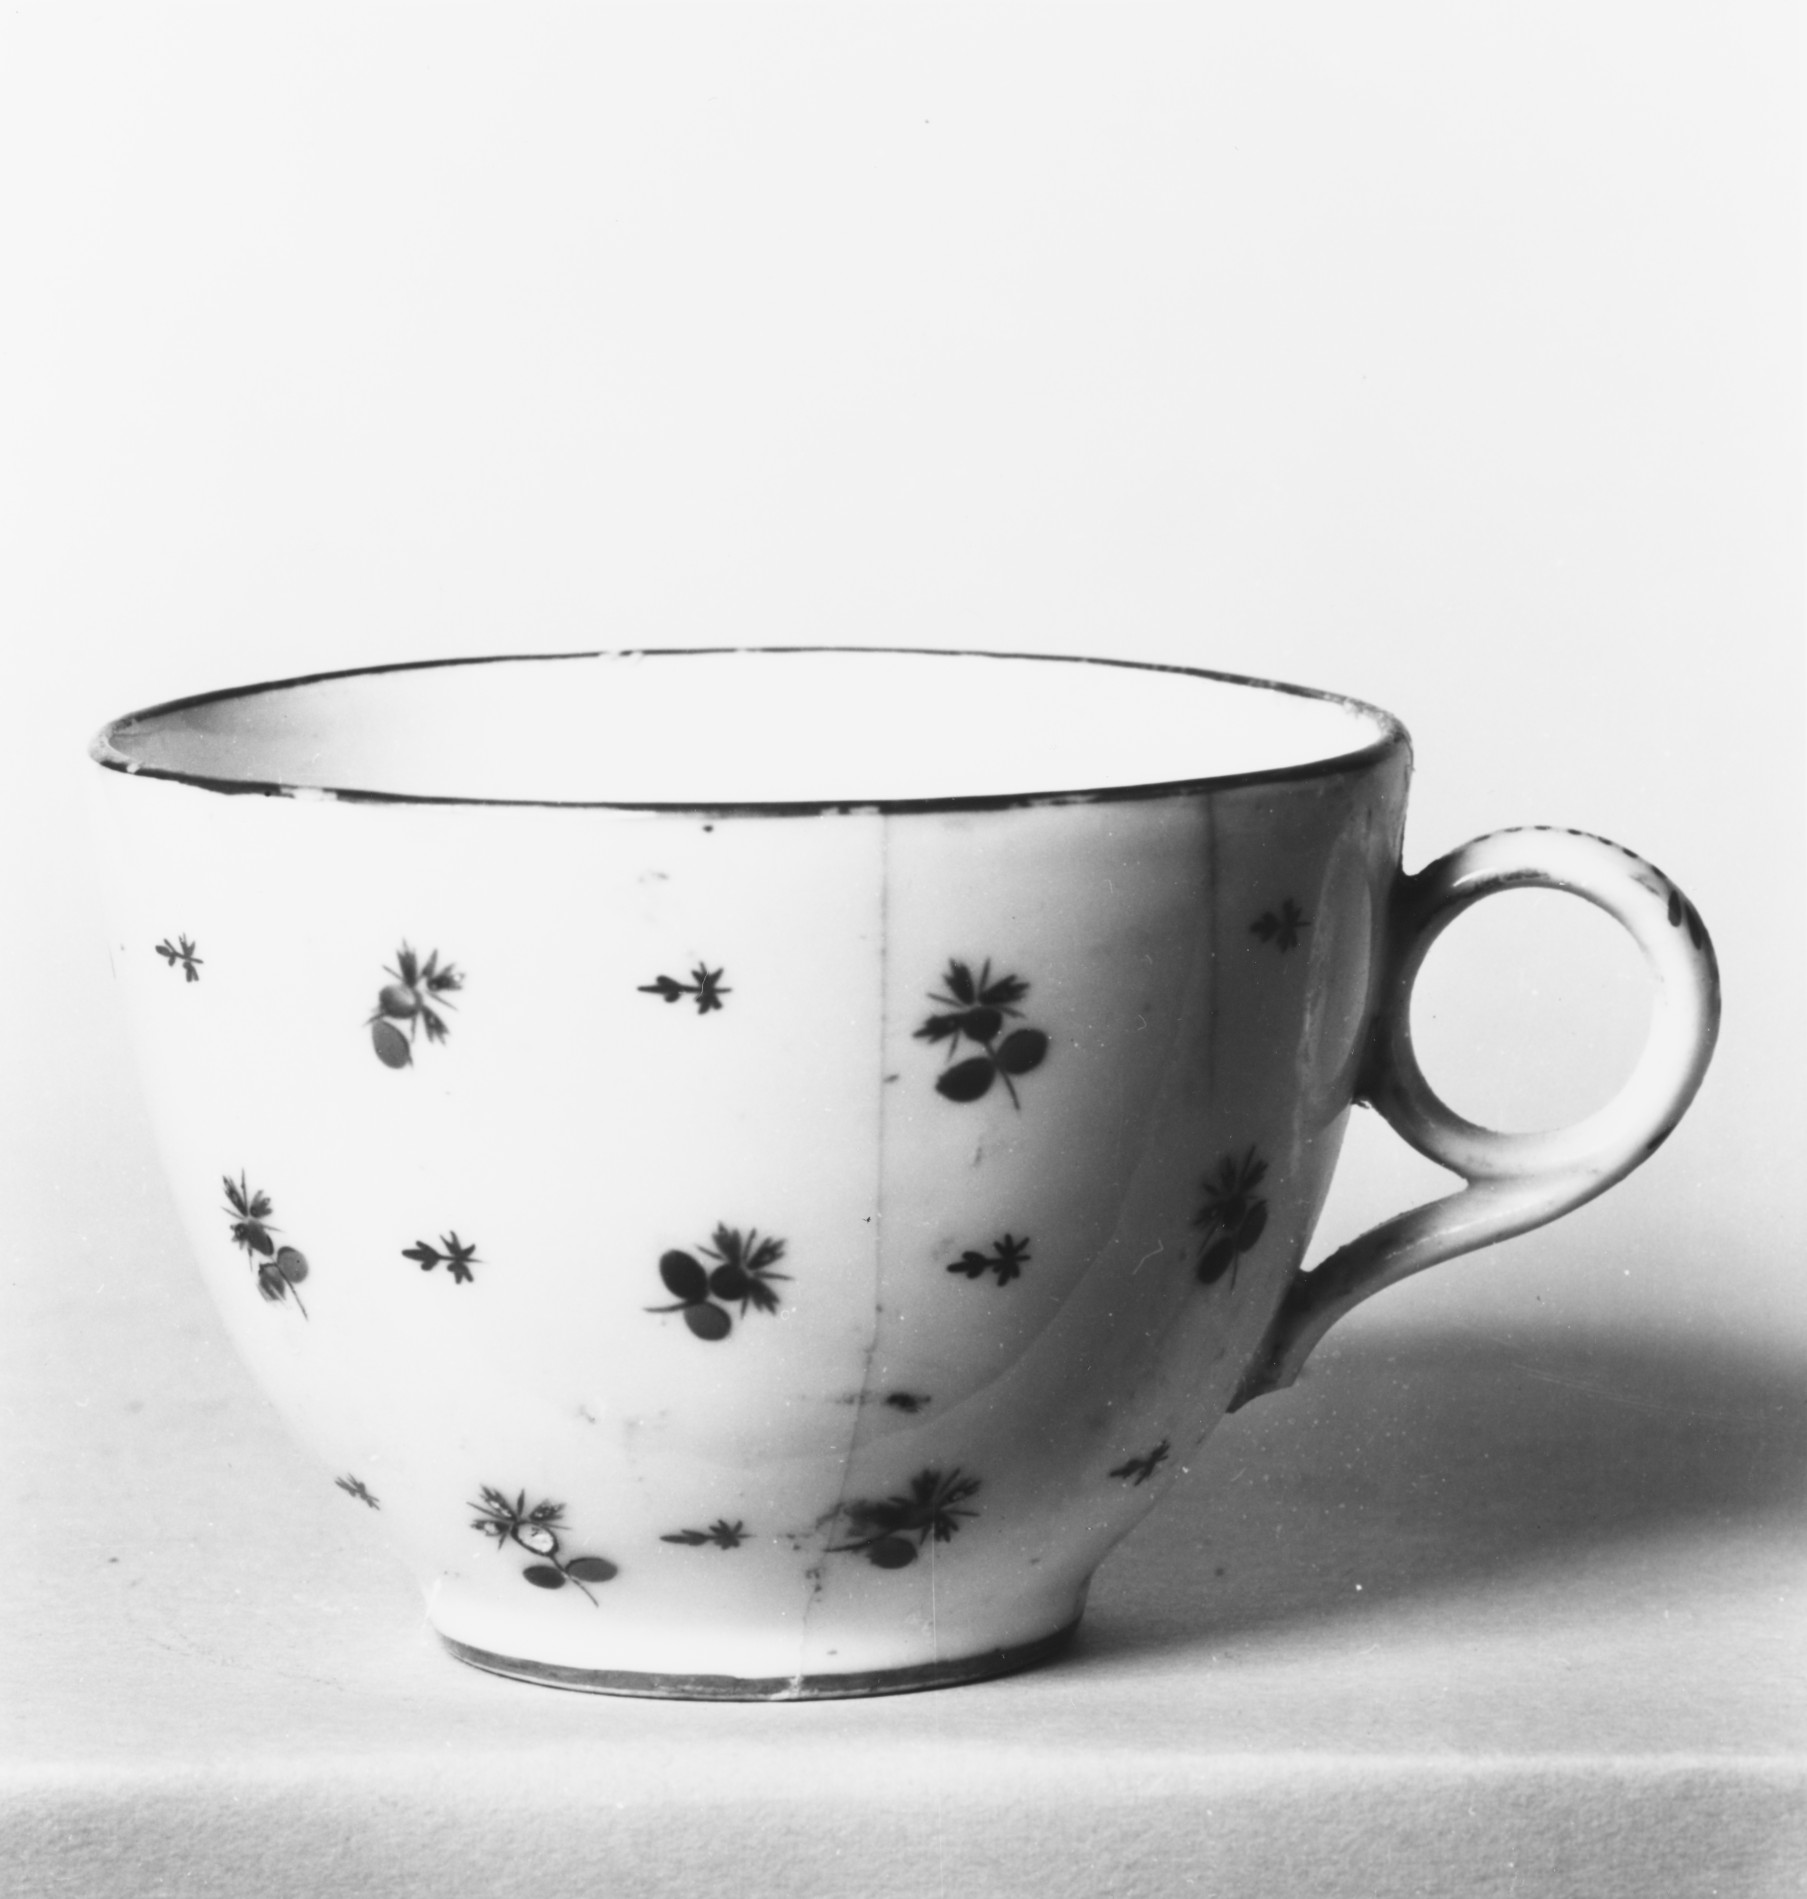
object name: cup and saucer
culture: french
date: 1780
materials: porcelain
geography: france